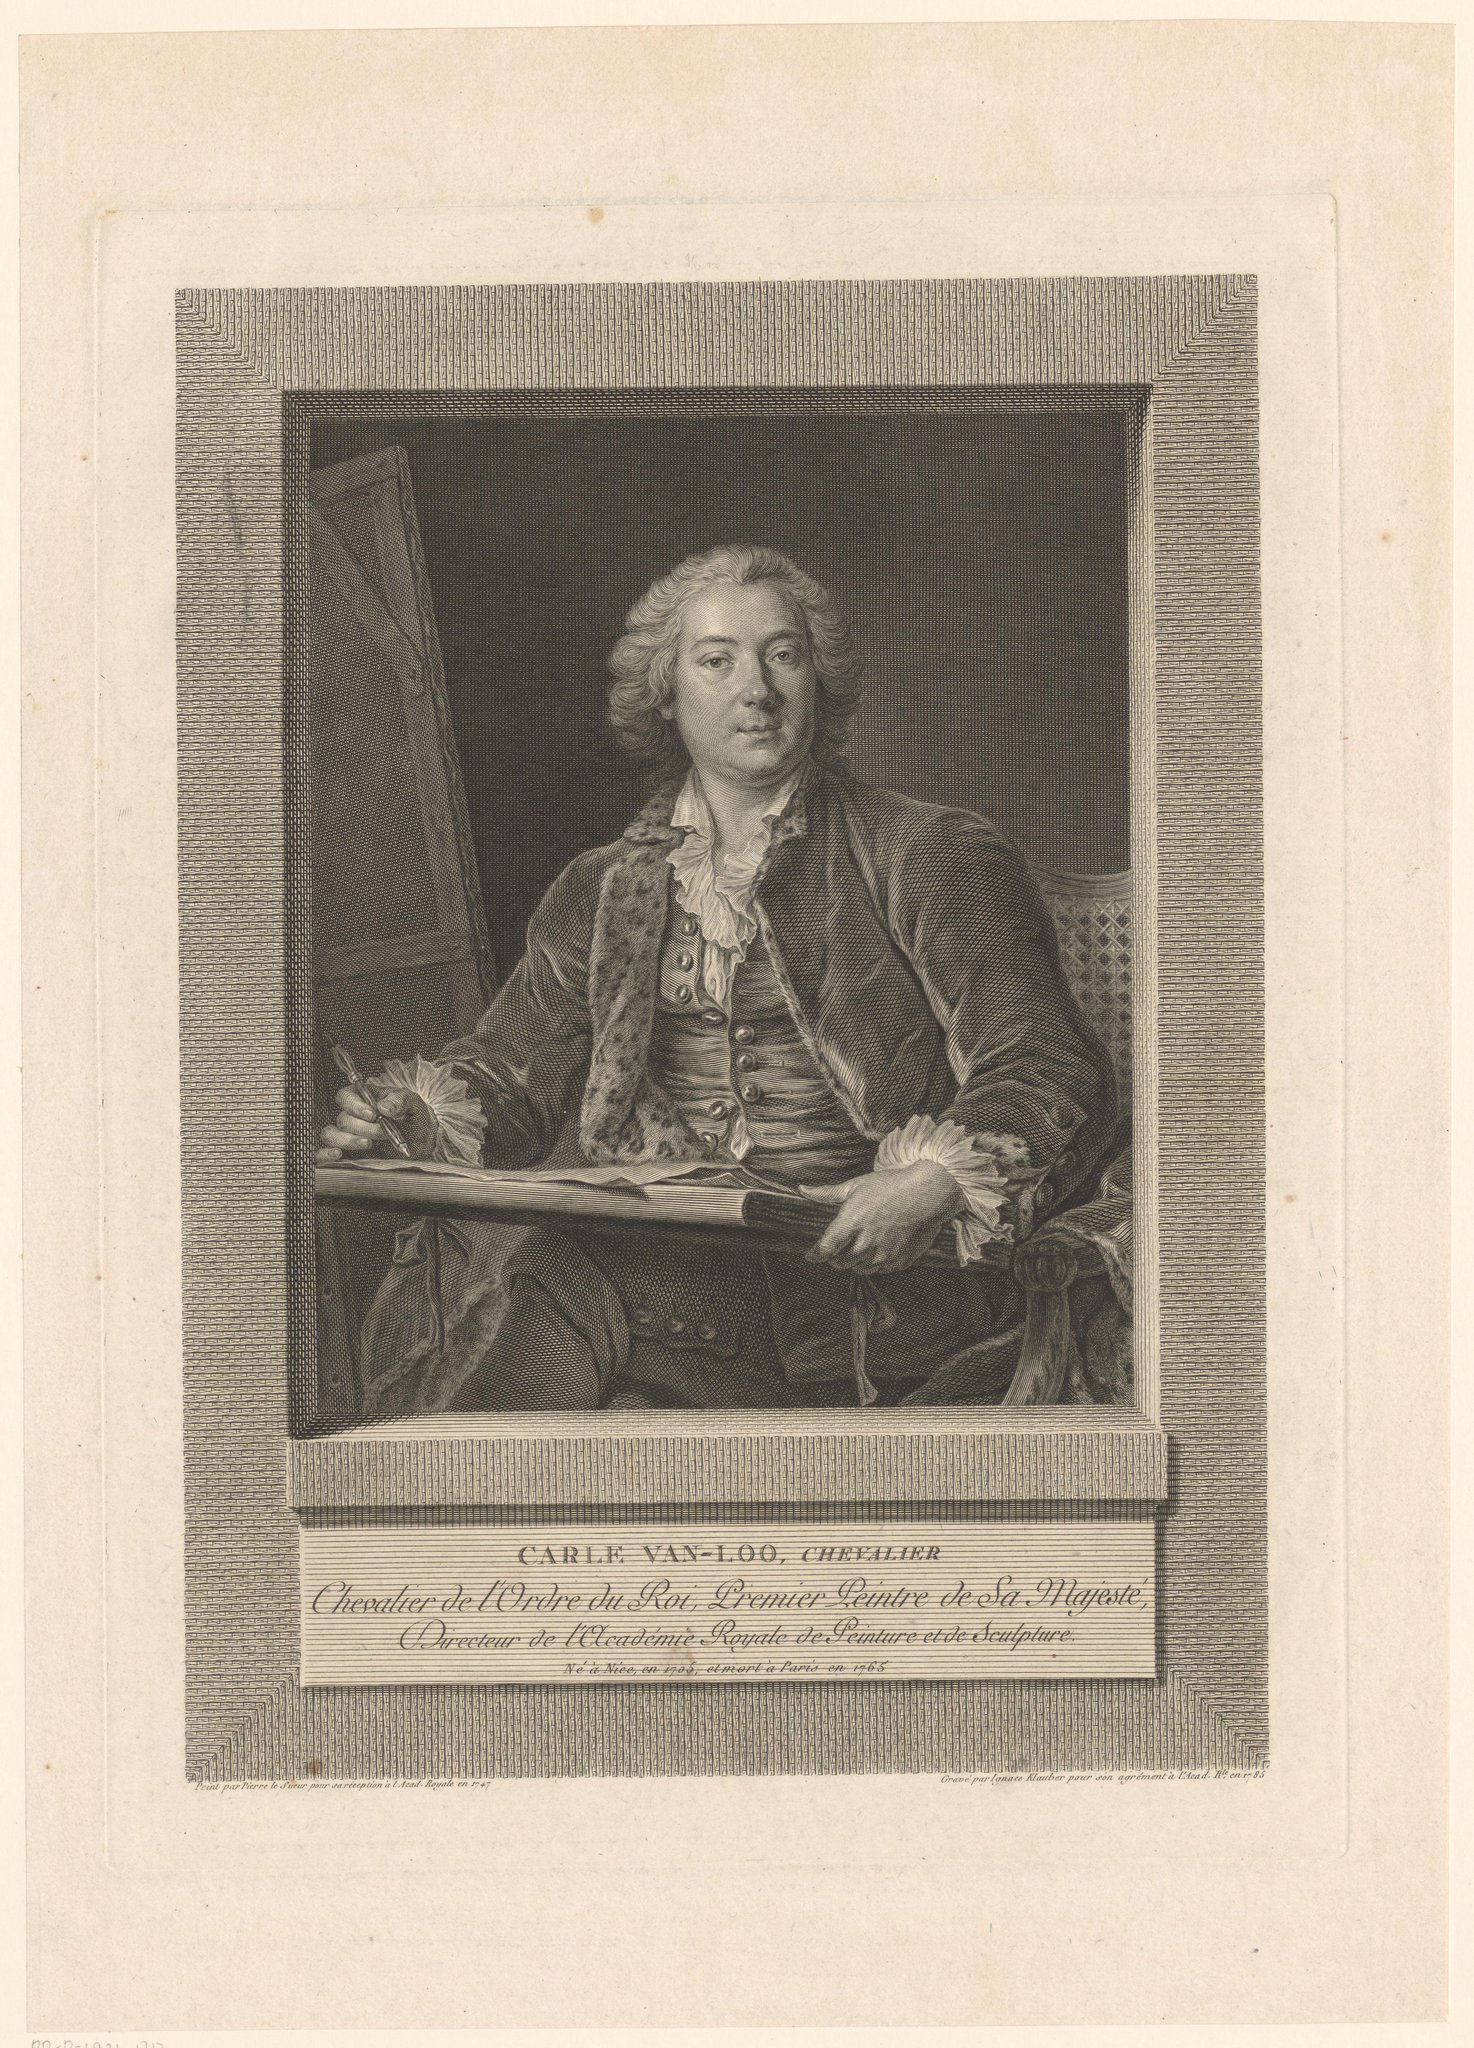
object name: print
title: Portret van Carle van Loo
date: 1785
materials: paper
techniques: engraving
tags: paris, painter, print maker, carle van loo, historical persons, portrait, self-portrait of painter, portrait, self-portrait of graphic artist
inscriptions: collector's mark: Lugt 2233